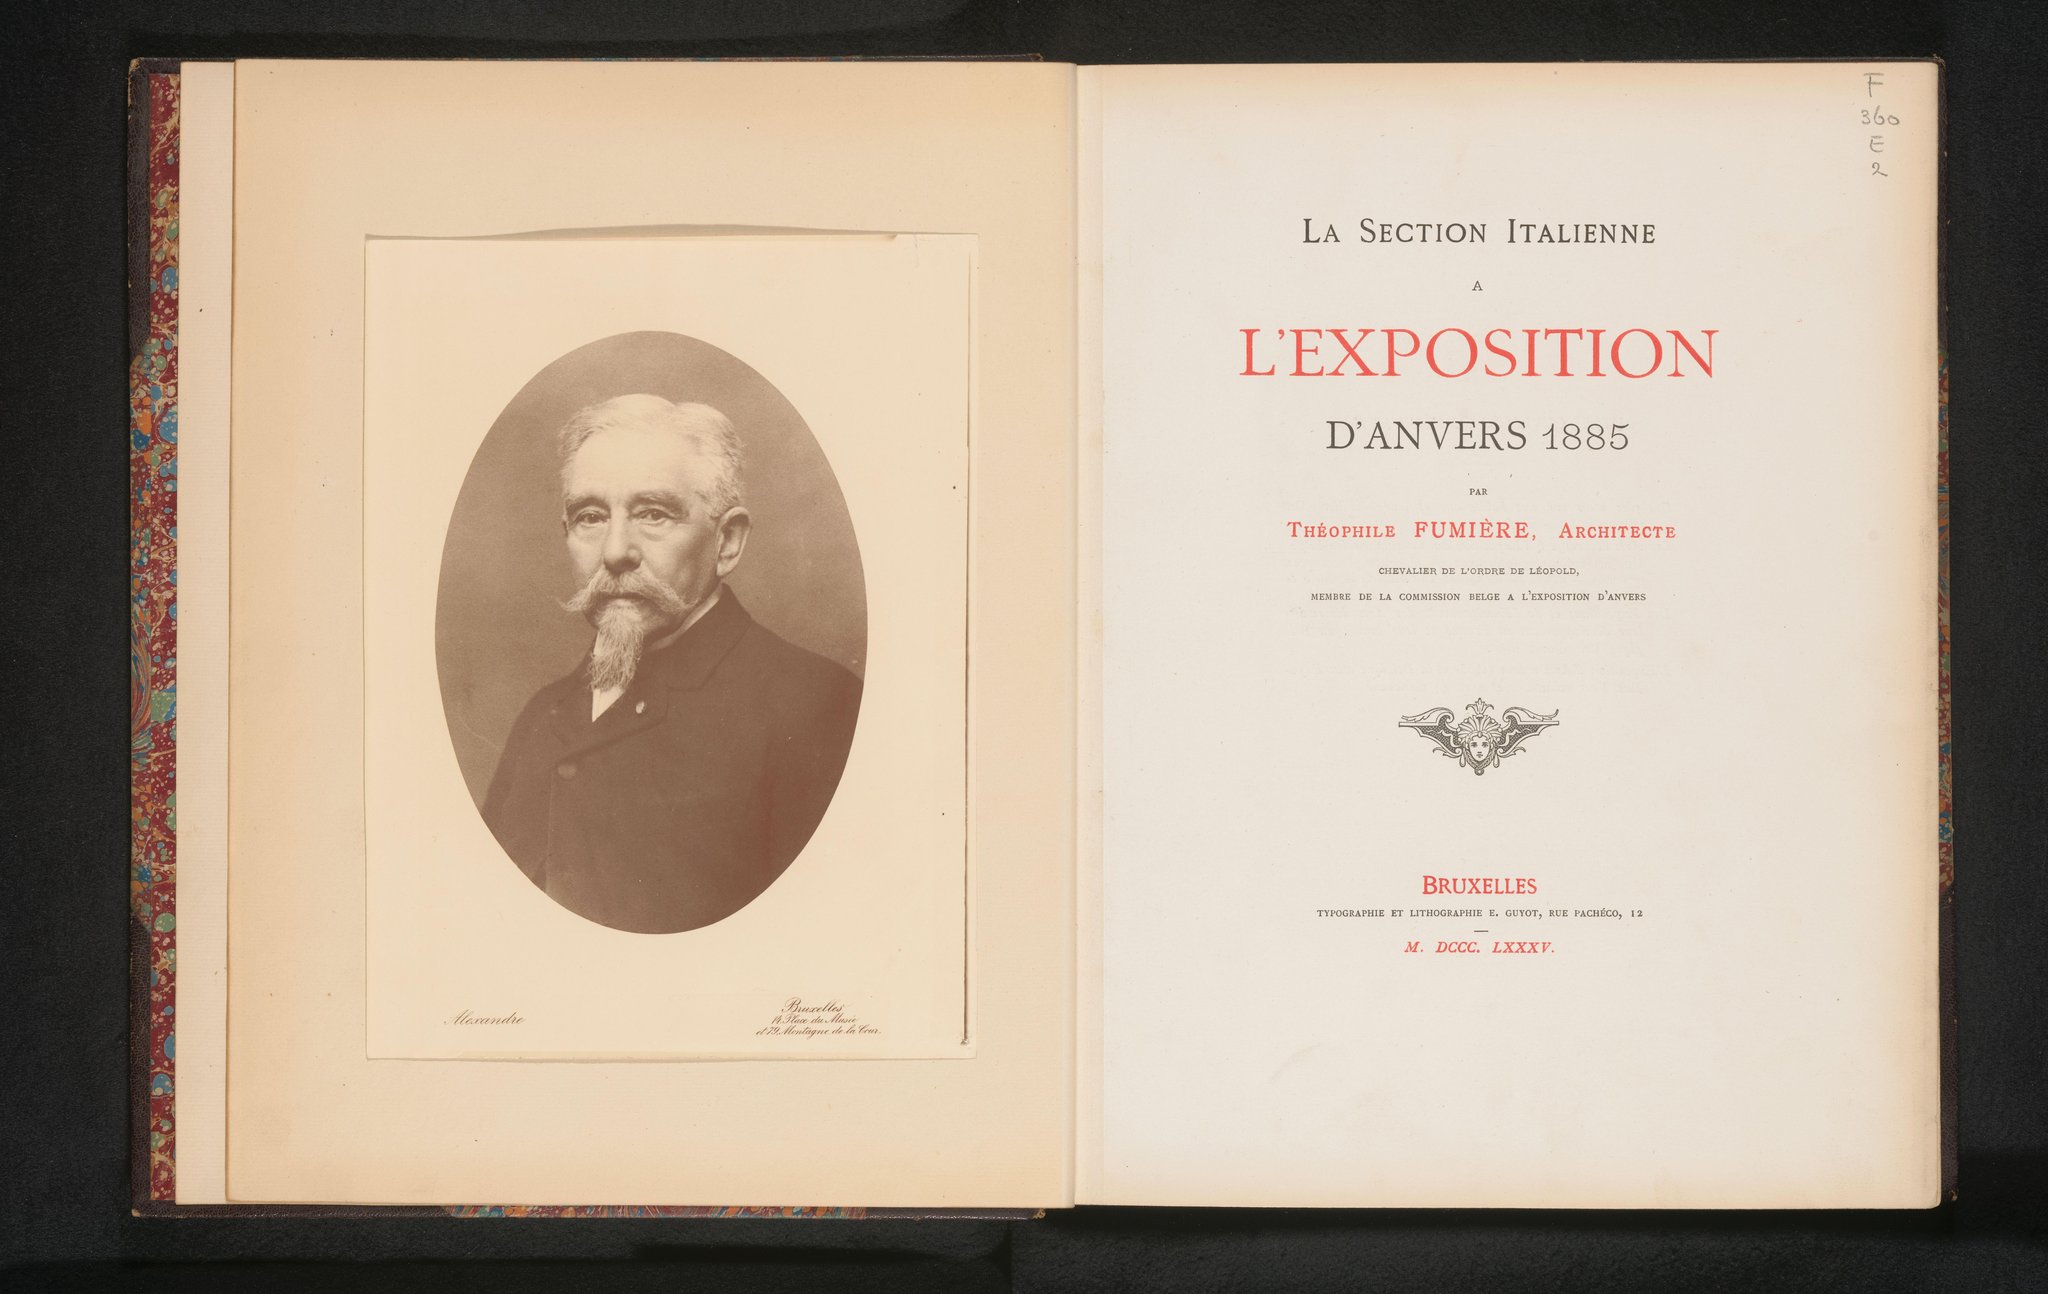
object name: photograph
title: Portret van een onbekende man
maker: Anonymous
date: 1880-1885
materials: photographic support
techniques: gelatin silver print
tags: historical persons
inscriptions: inscription: ‘Alexandre/ Bruxelles/ 14. Place du Musée/ et 79. Montagne de la Cour’